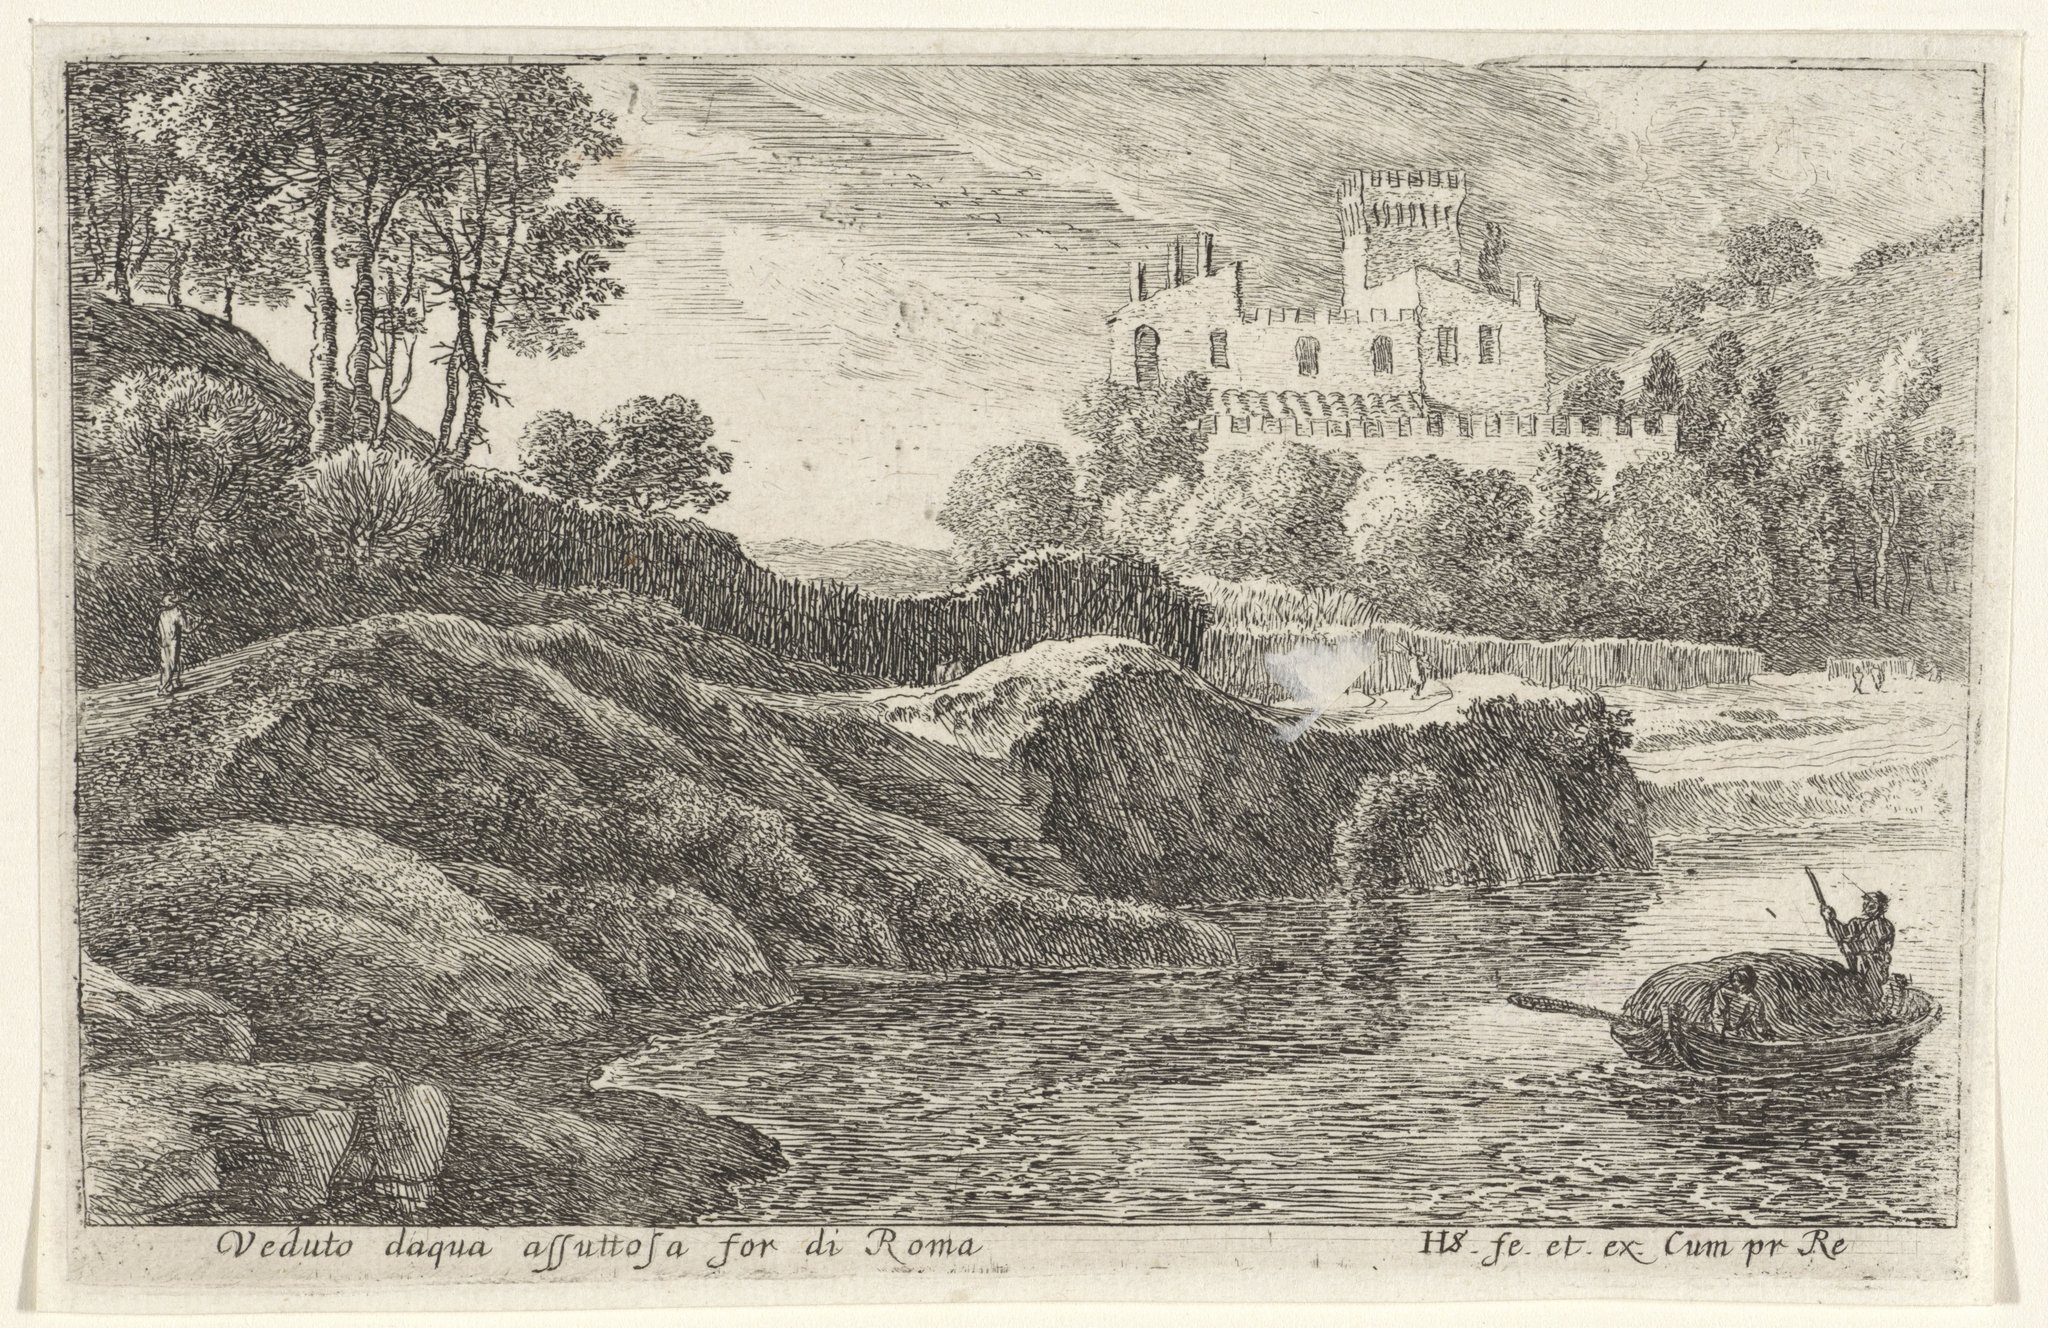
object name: print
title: Titelblad en twaalf gezichten op Rome en omgeving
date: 1652-1653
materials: paper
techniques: etching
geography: paris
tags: landscapes, rural housing, e.g. country-house, villa, cottage, spring (fluids extracted from the earth), tower (of house or building), rome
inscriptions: collector's mark: Lugt 240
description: Gezicht op de bron Acqua Acestosa te Rome met op de voorgrond een bemande vrachtboot en in de verte een versterkt gebouw met een toren op een heuvel.